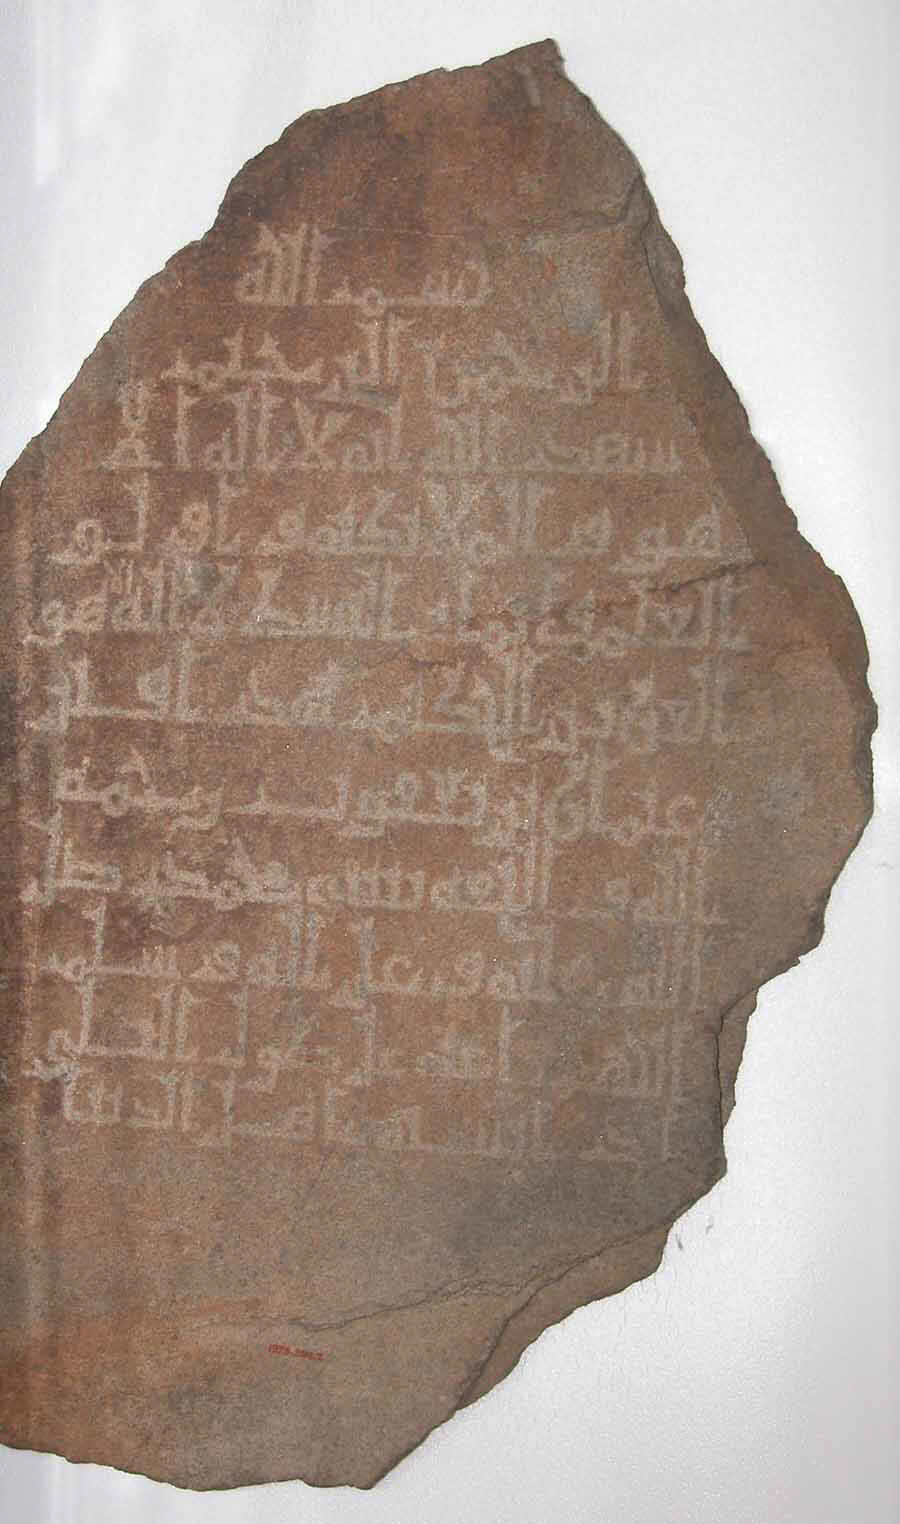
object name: tombstone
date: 901-1100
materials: granite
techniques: engraving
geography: egypt